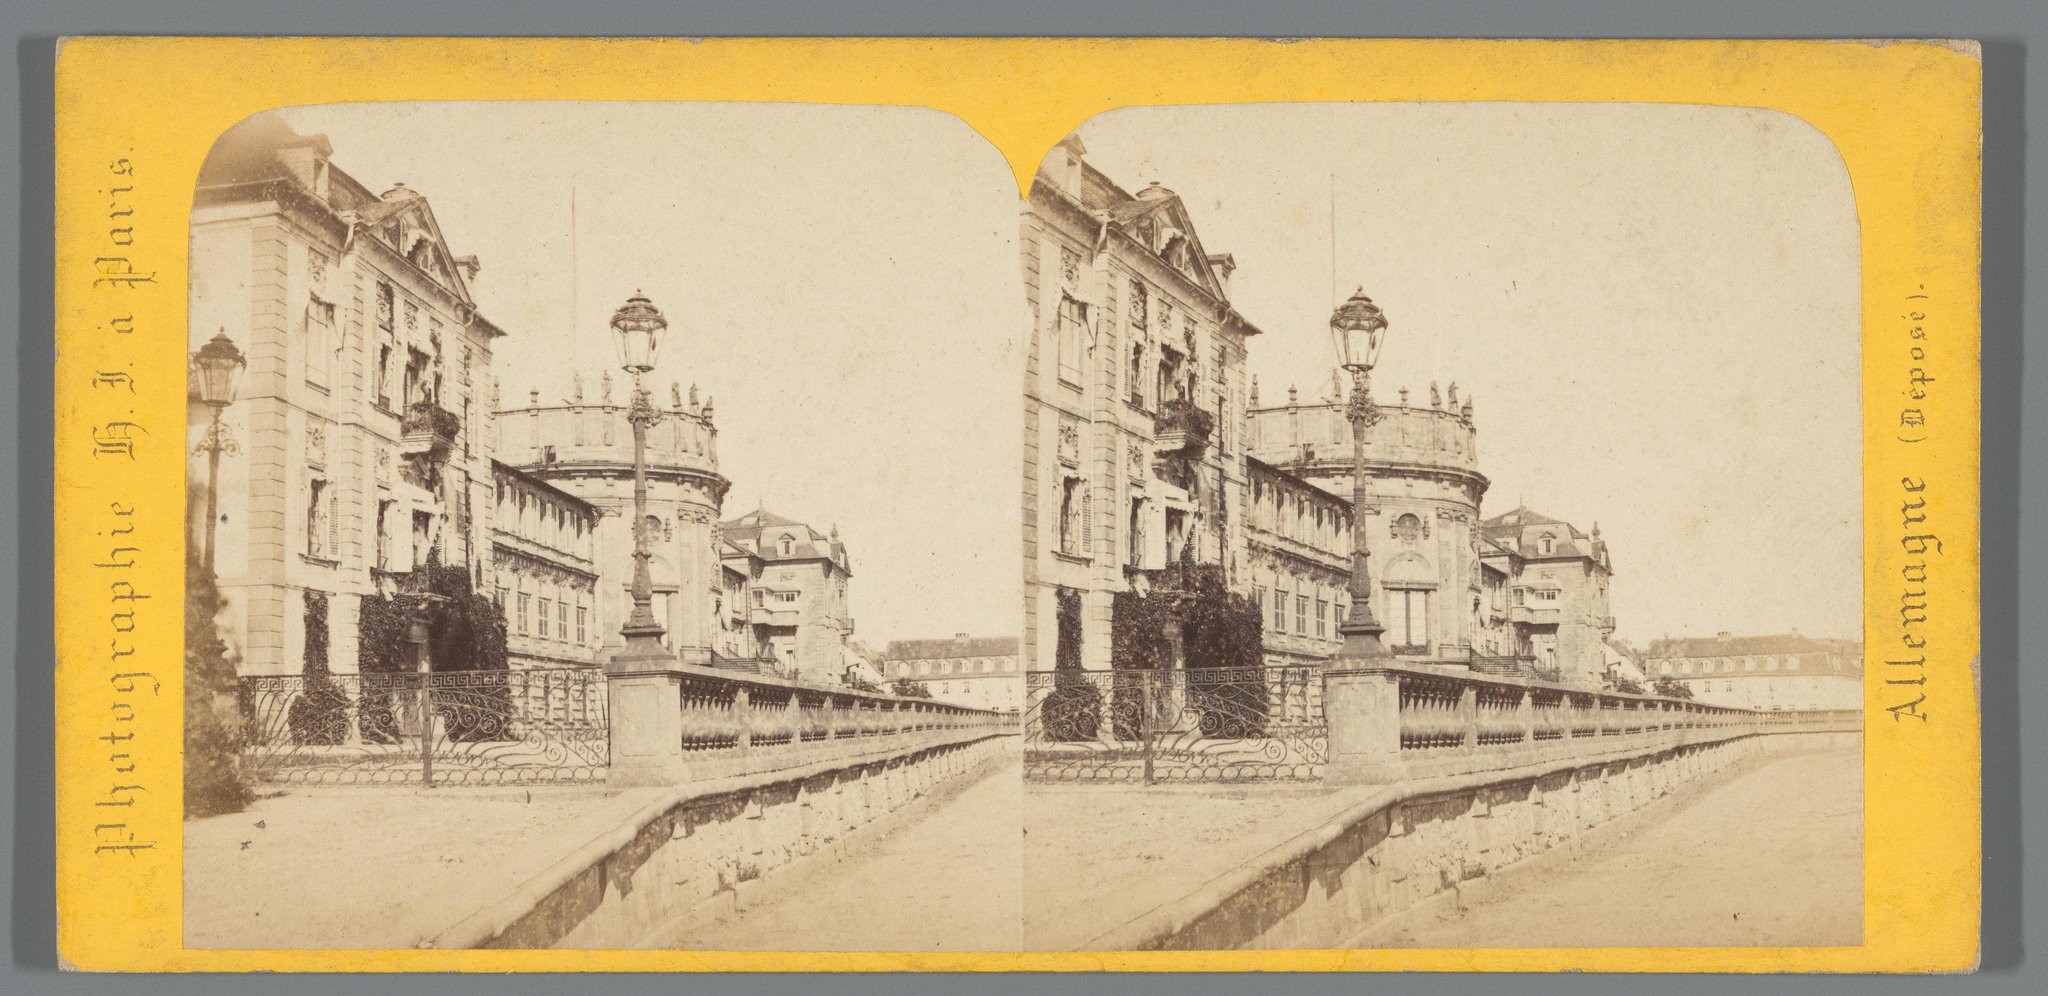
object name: stereograph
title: Gezicht op het slot Biebrich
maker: hippolyte jouvin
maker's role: fotograaf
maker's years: 1825-1889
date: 1861-1870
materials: cardboard, paper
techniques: albumen print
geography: biebrich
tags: fortress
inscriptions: number: ‘N. 443’, inscription: ‘Déposé.’